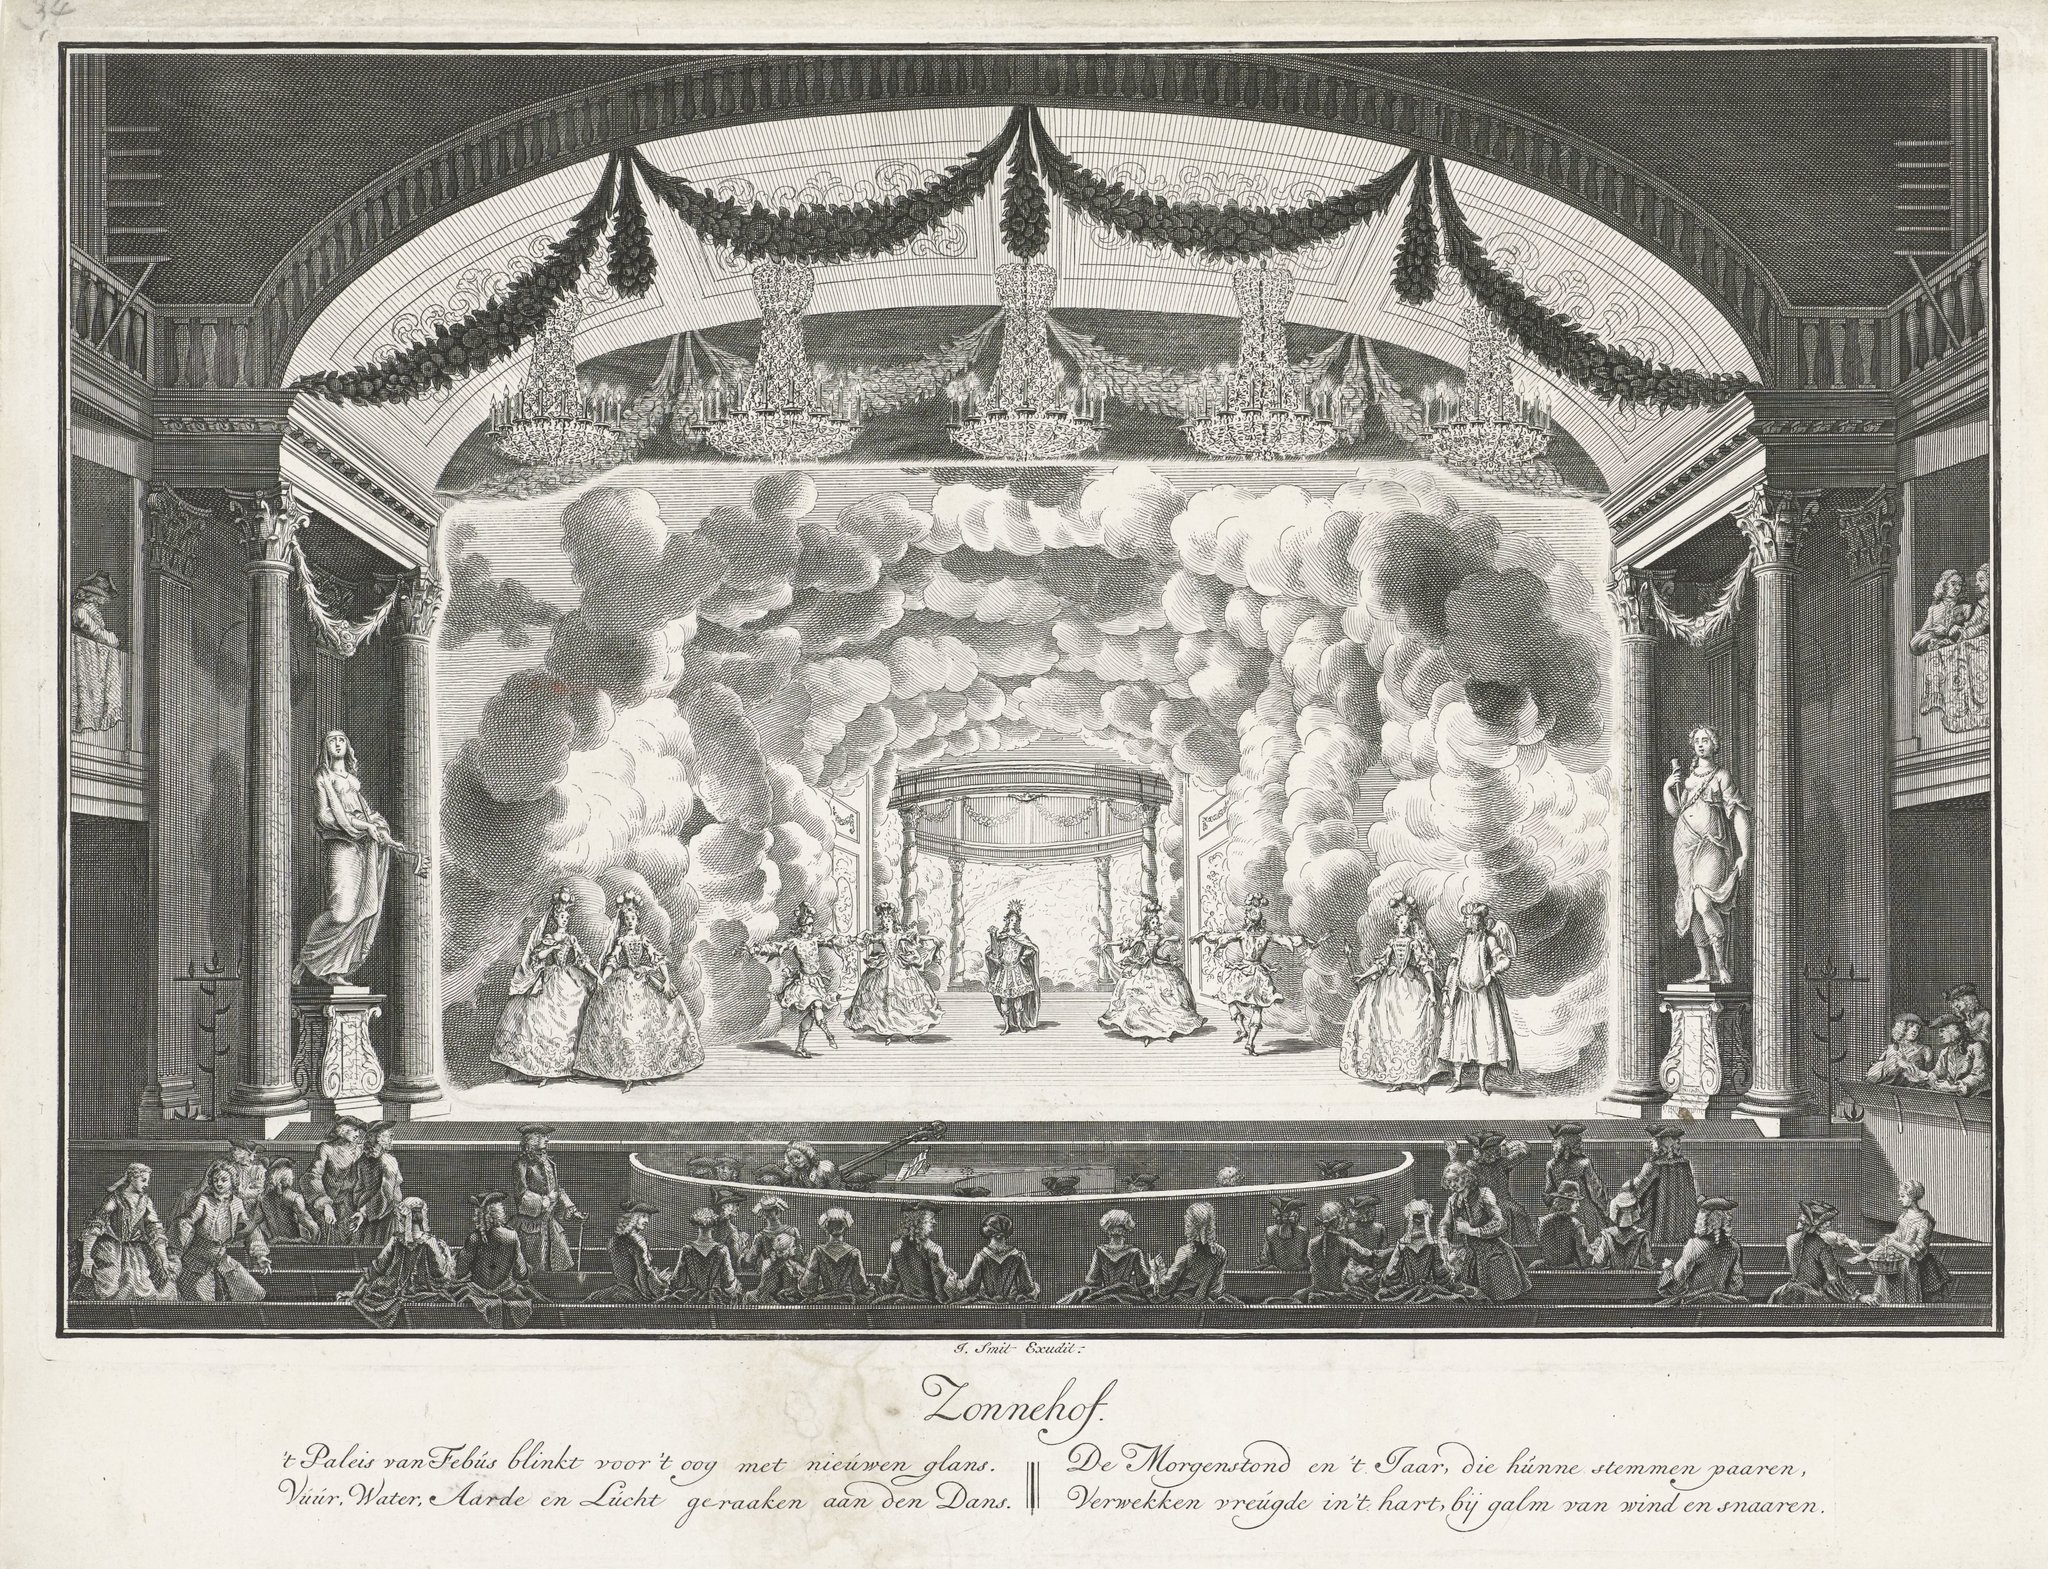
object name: print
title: Zonnehof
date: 1738-1740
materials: paper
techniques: engraving, etching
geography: amsterdam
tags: theatre, theatrical performance, stage design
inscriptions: collector's mark: Lugt 2228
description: Toneelvoorstelling in de Amsterdamse Schouwburg op de Keizersgracht met het coulissendecor Zonnehof met scène uit: Het eeuwgetijde van den Amsteldamschen Schouwburg. Het decor gedrukt van een aparte plaat binnen een passe-partout met de zaal, zijloges, orkestbak en de façade van het toneel met zuilen, guirlandes en kroonluchters. De titel en een vierregelig vers ook gedrukt van een aparte plaat. Onderdeel van een serie van 12 toneeldecors.